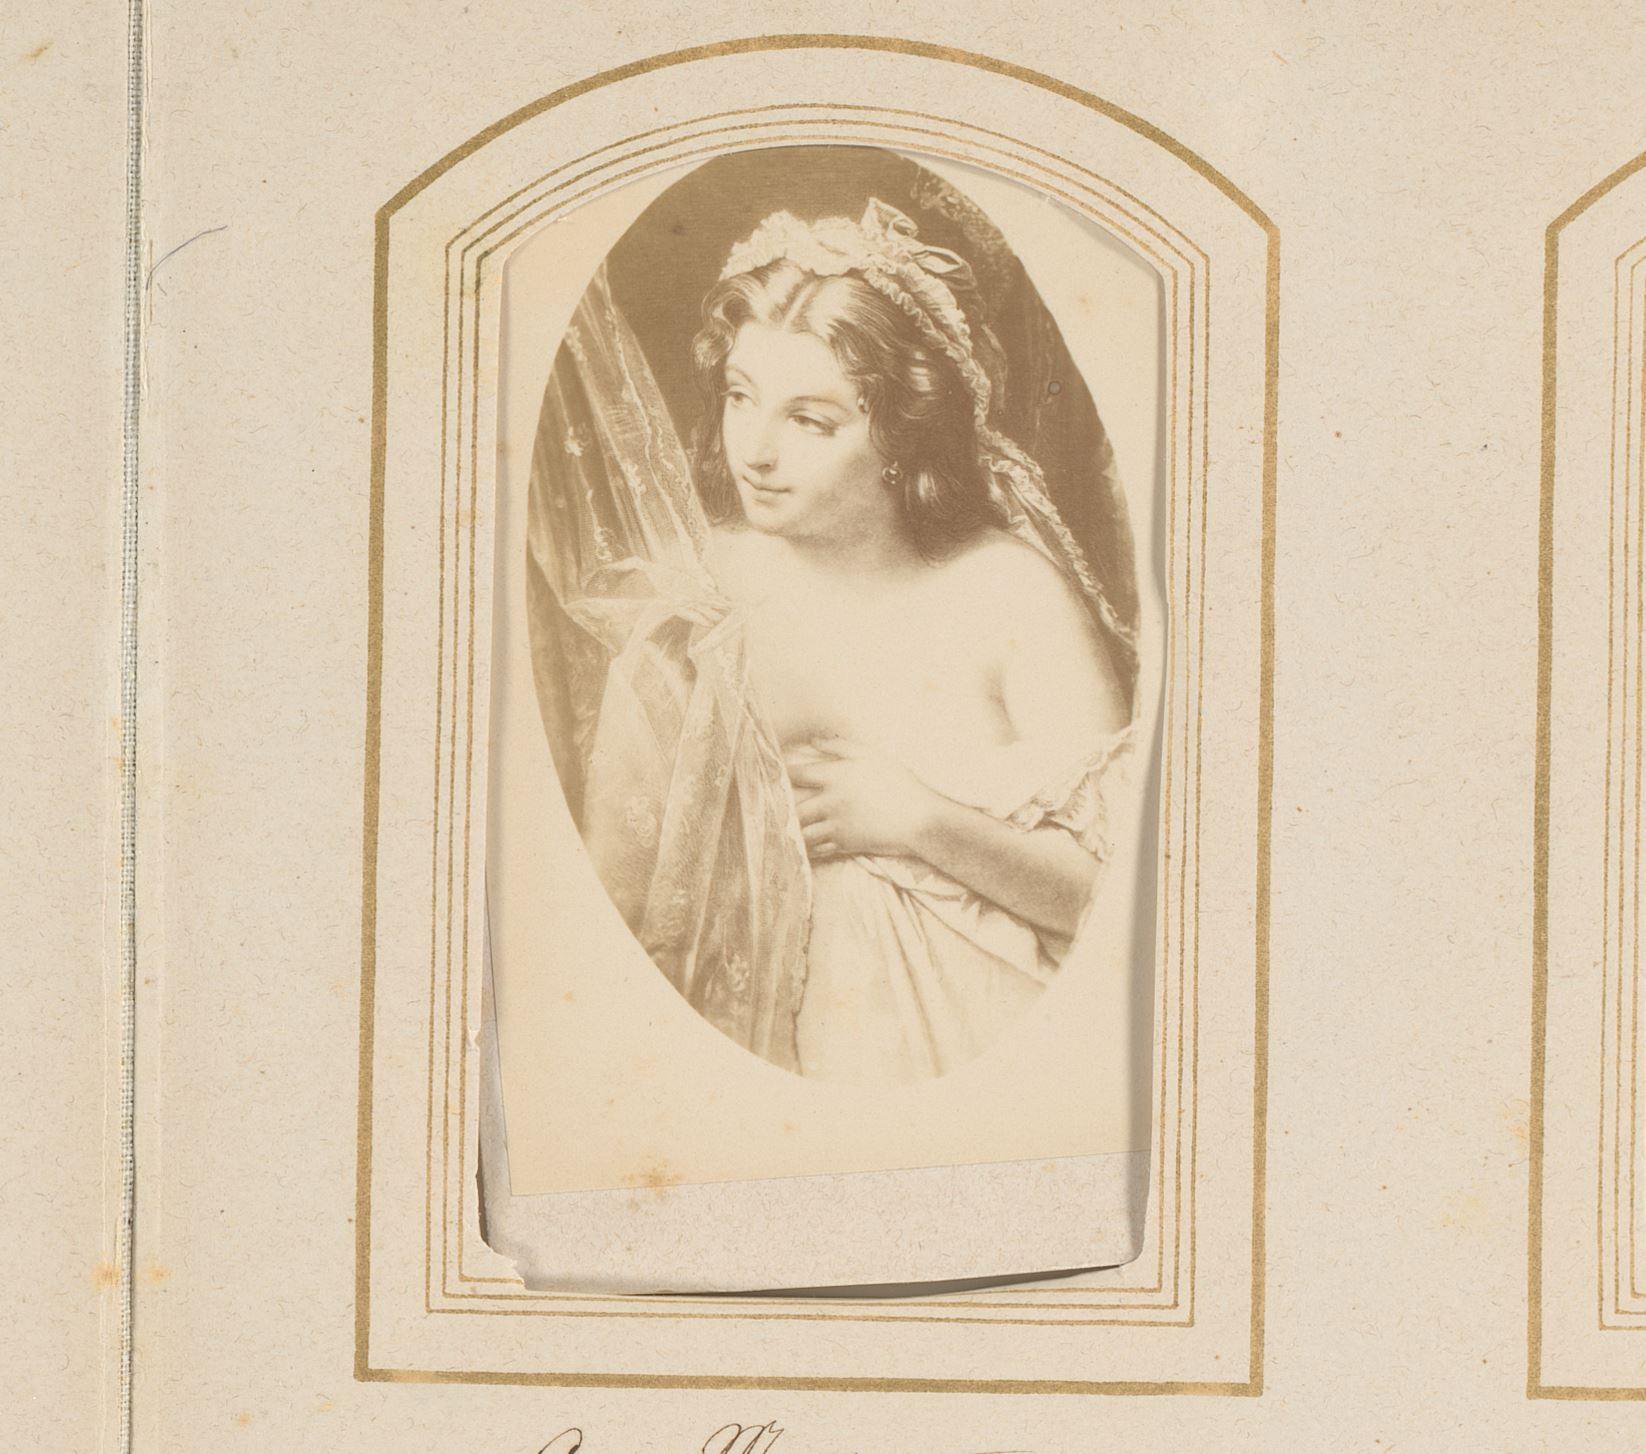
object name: photograph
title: Fotoreproductie van Am Morgen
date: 1870-1890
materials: cardboard, photographic support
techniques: albumen print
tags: adolescent, young woman, maiden, painting, drawing and the graphic arts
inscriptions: number: ‘145’, annotation: ‘Am Morgen’